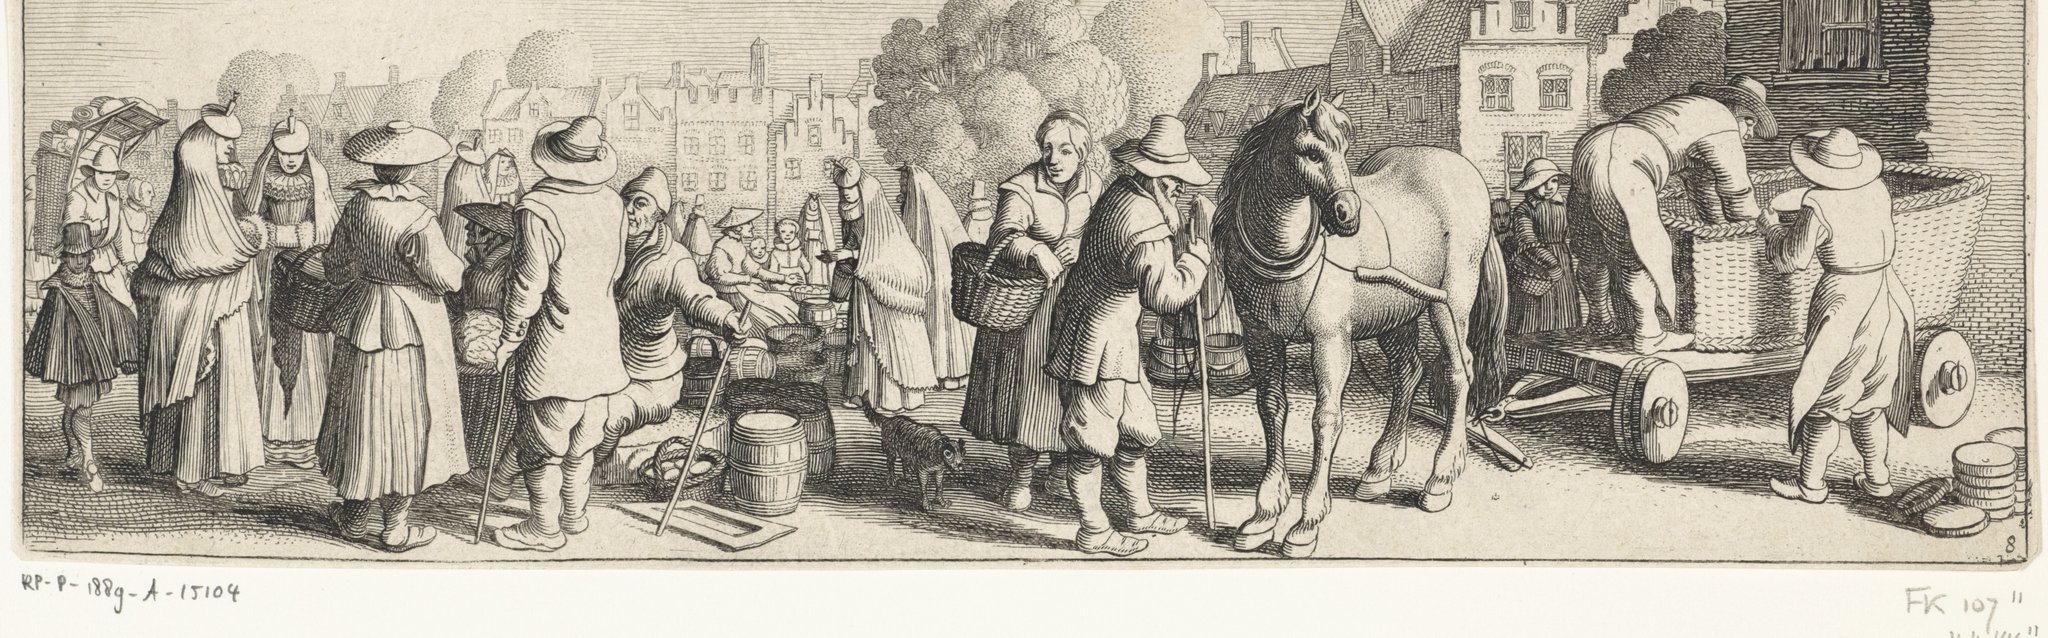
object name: print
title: Markt, serie B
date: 1603-1652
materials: paper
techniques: engraving, etching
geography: northern netherlands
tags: cape (huik) (+ women's clothes), clothes, costume (+ women's clothes), clothes, costume (+ men's clothes), market, (farm) wagon, freight wagon, cart, traffic and transport (+ unloading)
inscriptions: collector's mark: Lugt 2228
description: Markttafereel met rechts op de voorgrond een paard voor een kar met rieten mand erop. De mand wordt uitgeladen door twee mannen. Op de achtergrond huizen. Vierde prent van een fries bestaande uit vier prenten, voorstellende een markt. Achtste prent uit de totale serie markten (serie markt A + B).